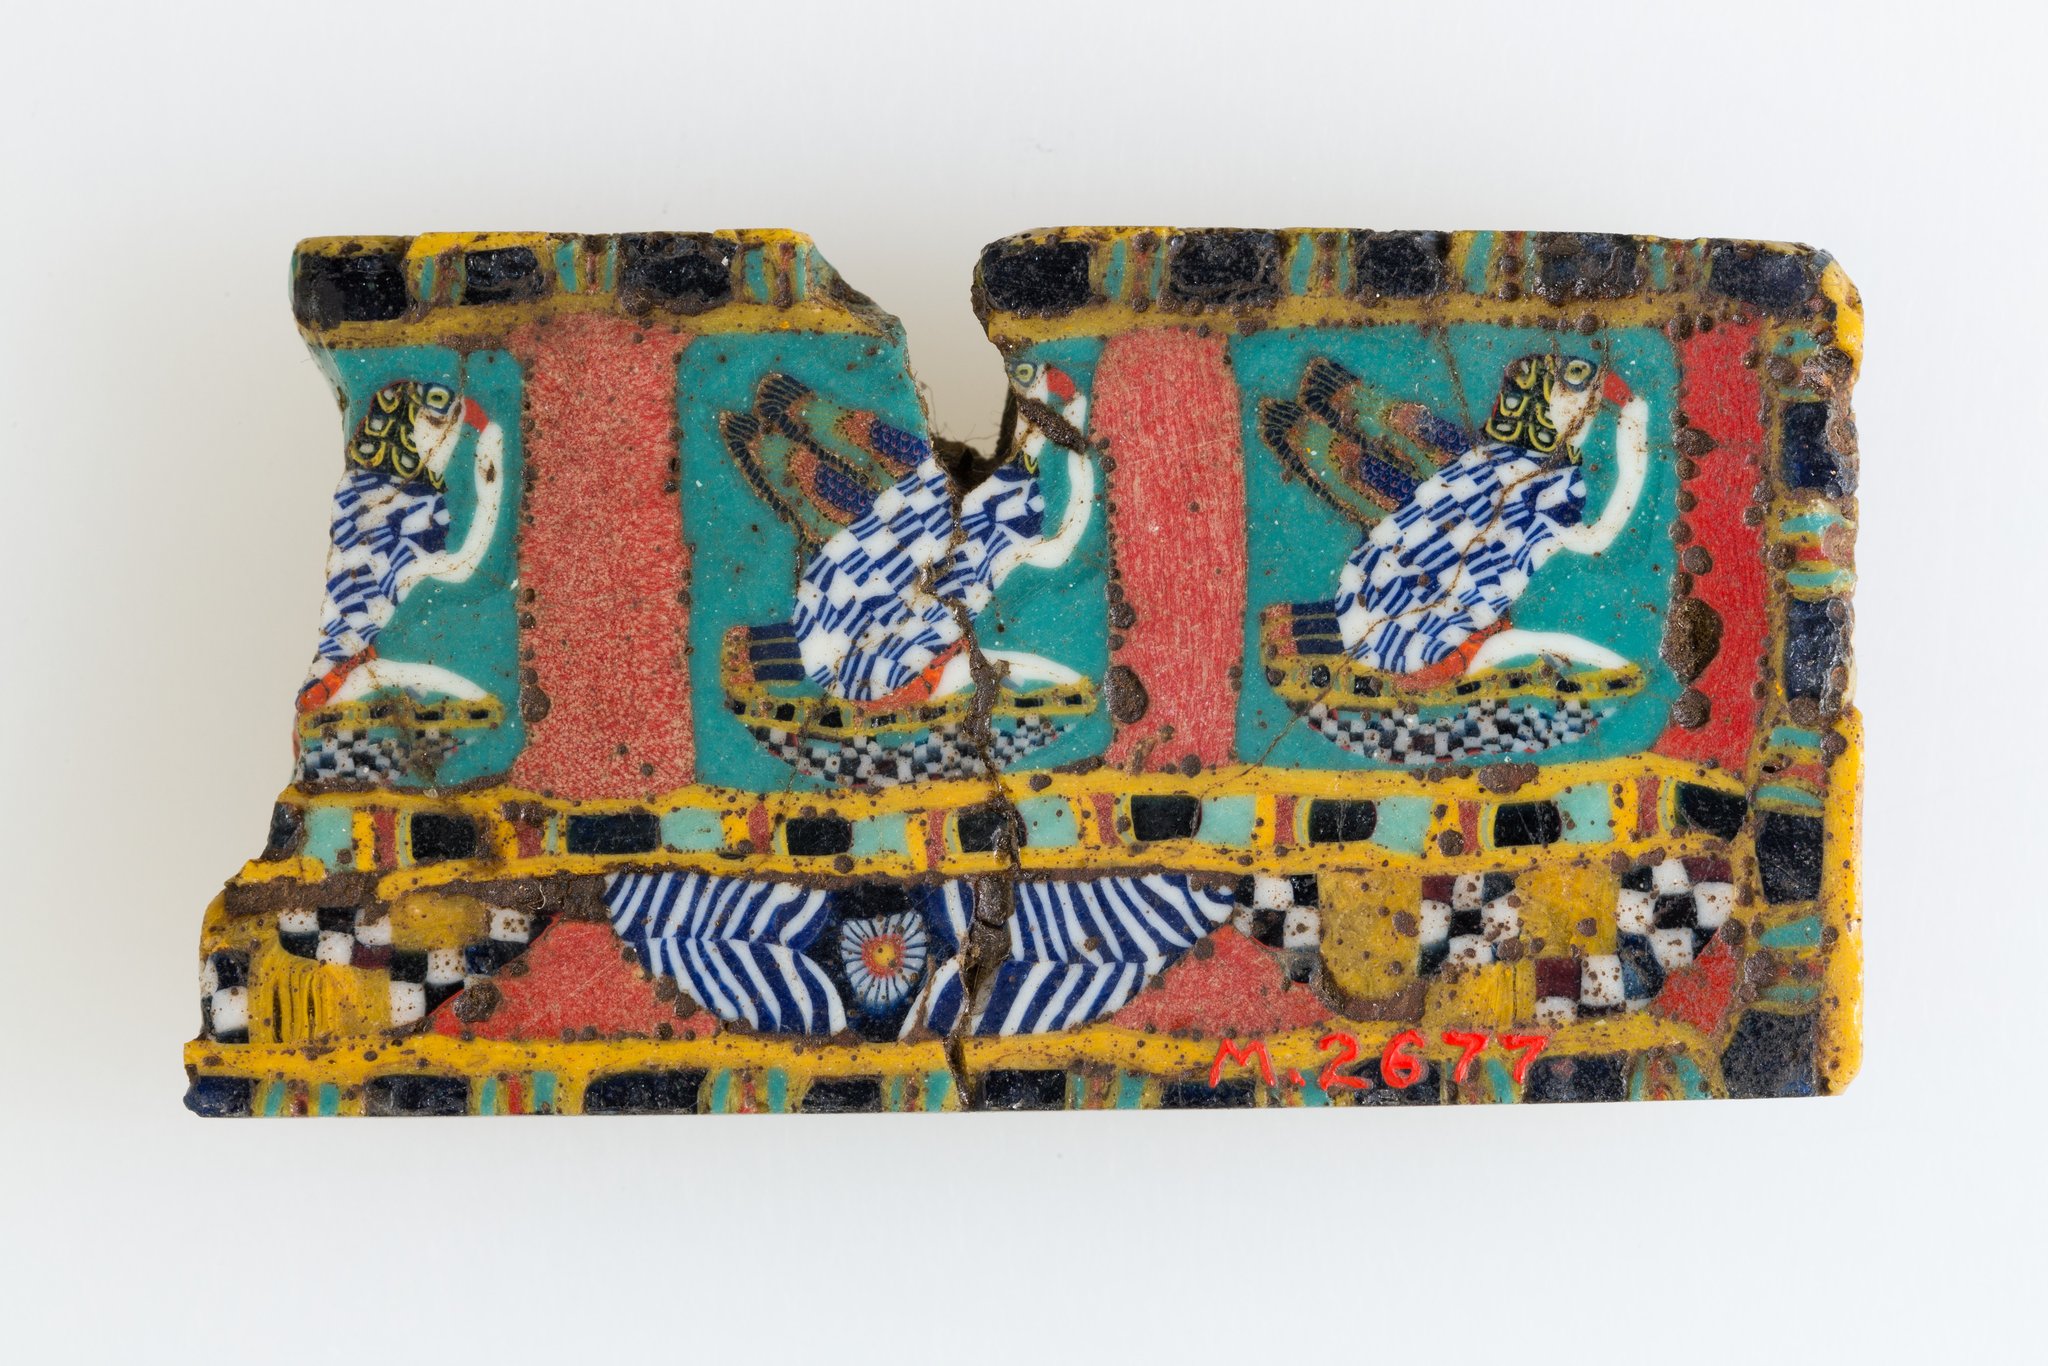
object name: inlay fragment, rekhyt bird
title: Inlay fragment, rekhyt birds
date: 100 BCE-100 CE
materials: glass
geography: egypt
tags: birds